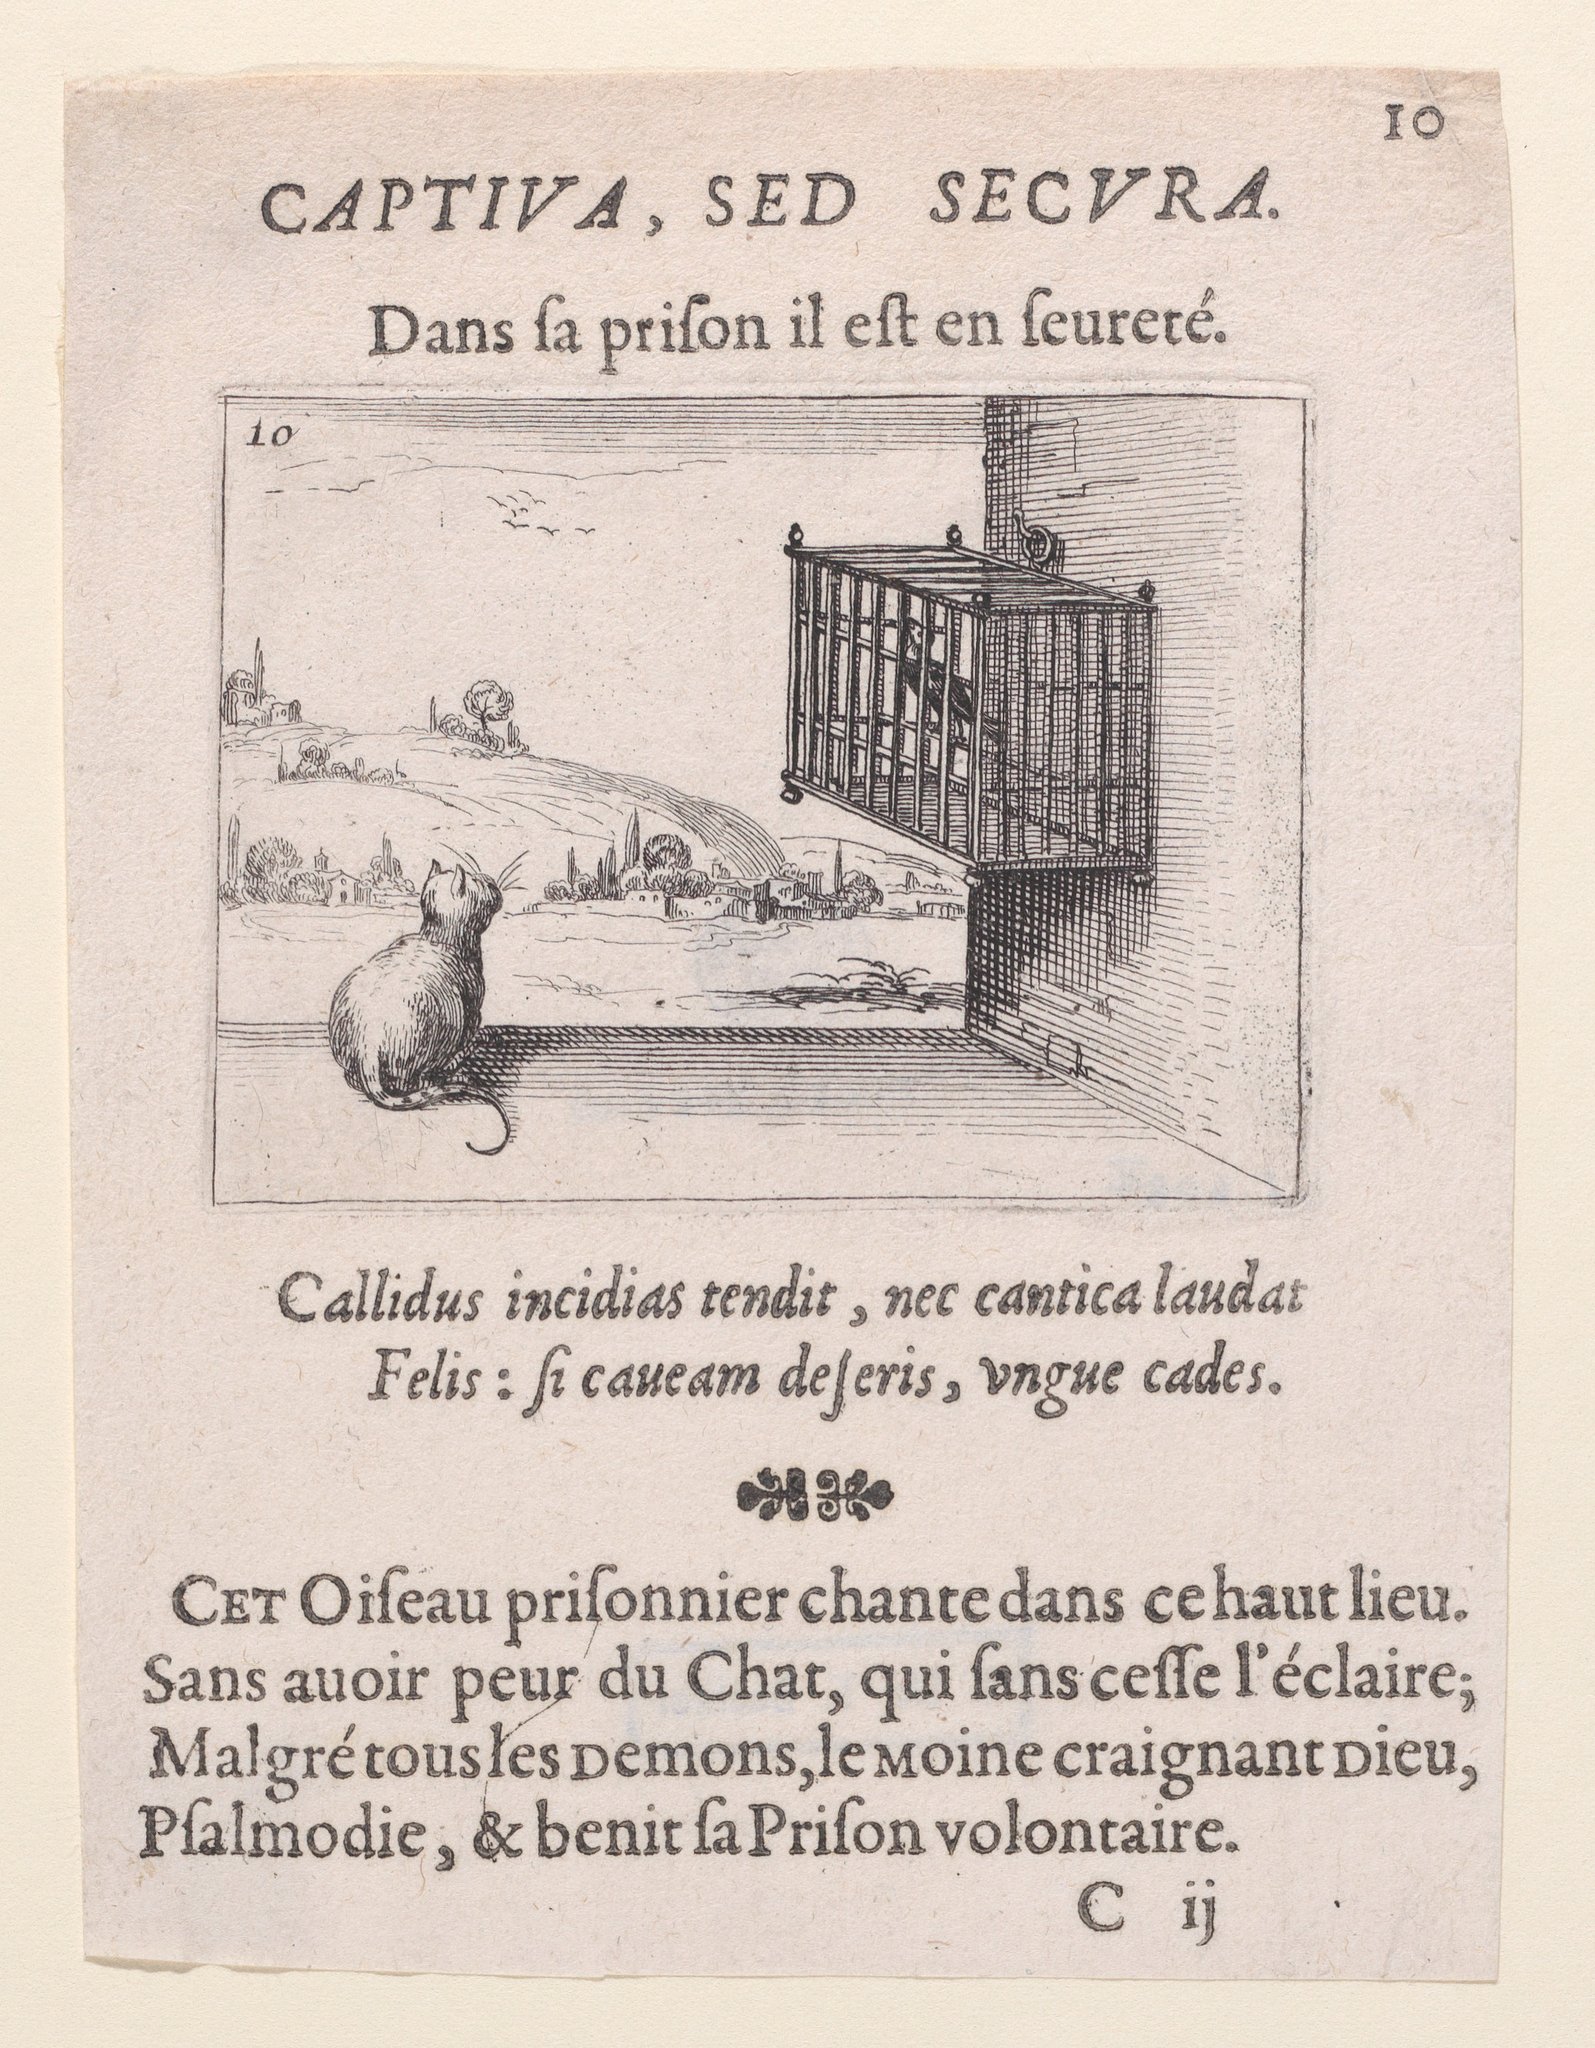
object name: print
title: Le Chat Guettant L'Oiseau en Cage (The Cat Watching the Bird in the Cage), plate 10 from "Lux Claustri ou La Lumière du Cloitre" (The Light of the Cloisters)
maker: jacques callot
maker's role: artist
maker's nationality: french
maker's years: 1592-1635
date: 1621-1635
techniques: etching, letterpress